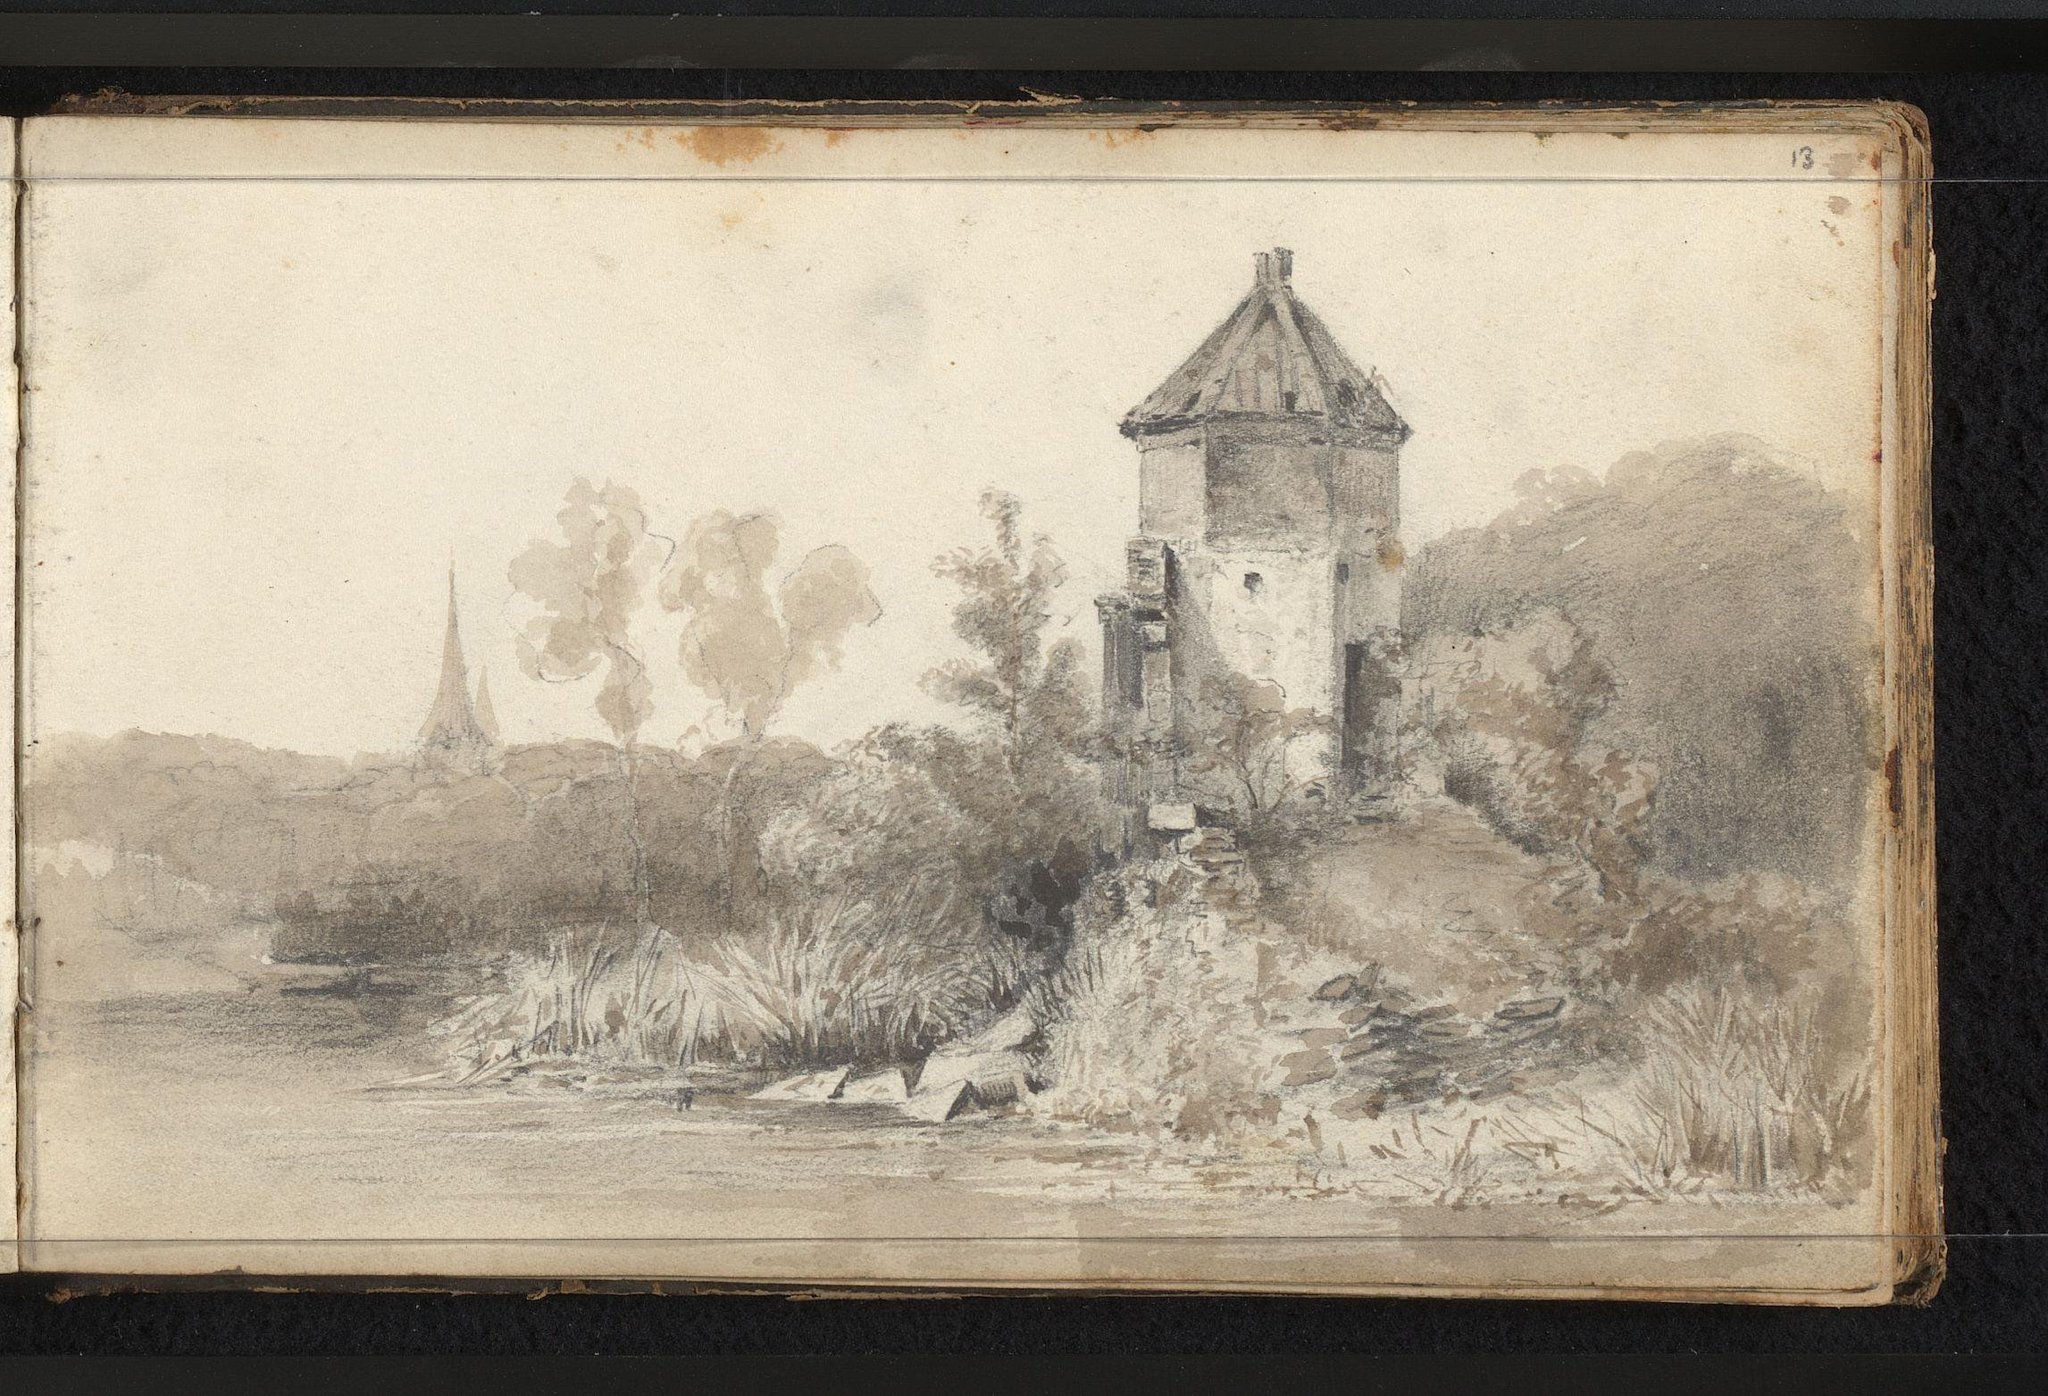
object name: sketchbook leaf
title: Toren aan het water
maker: jan bedijs tom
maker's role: draughtsman, painter, print maker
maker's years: 1813-1894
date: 1828-1894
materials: paper, pencil, watercolor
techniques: brush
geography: the hague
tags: plants; vegetation, landscapes with waters, waterscapes, seascapes (in the temperate zone), artist (in general) making preliminary designs, sketching, tower (of house or building)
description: Pagina 13 recto uit een schetsboek met 54 bladen.